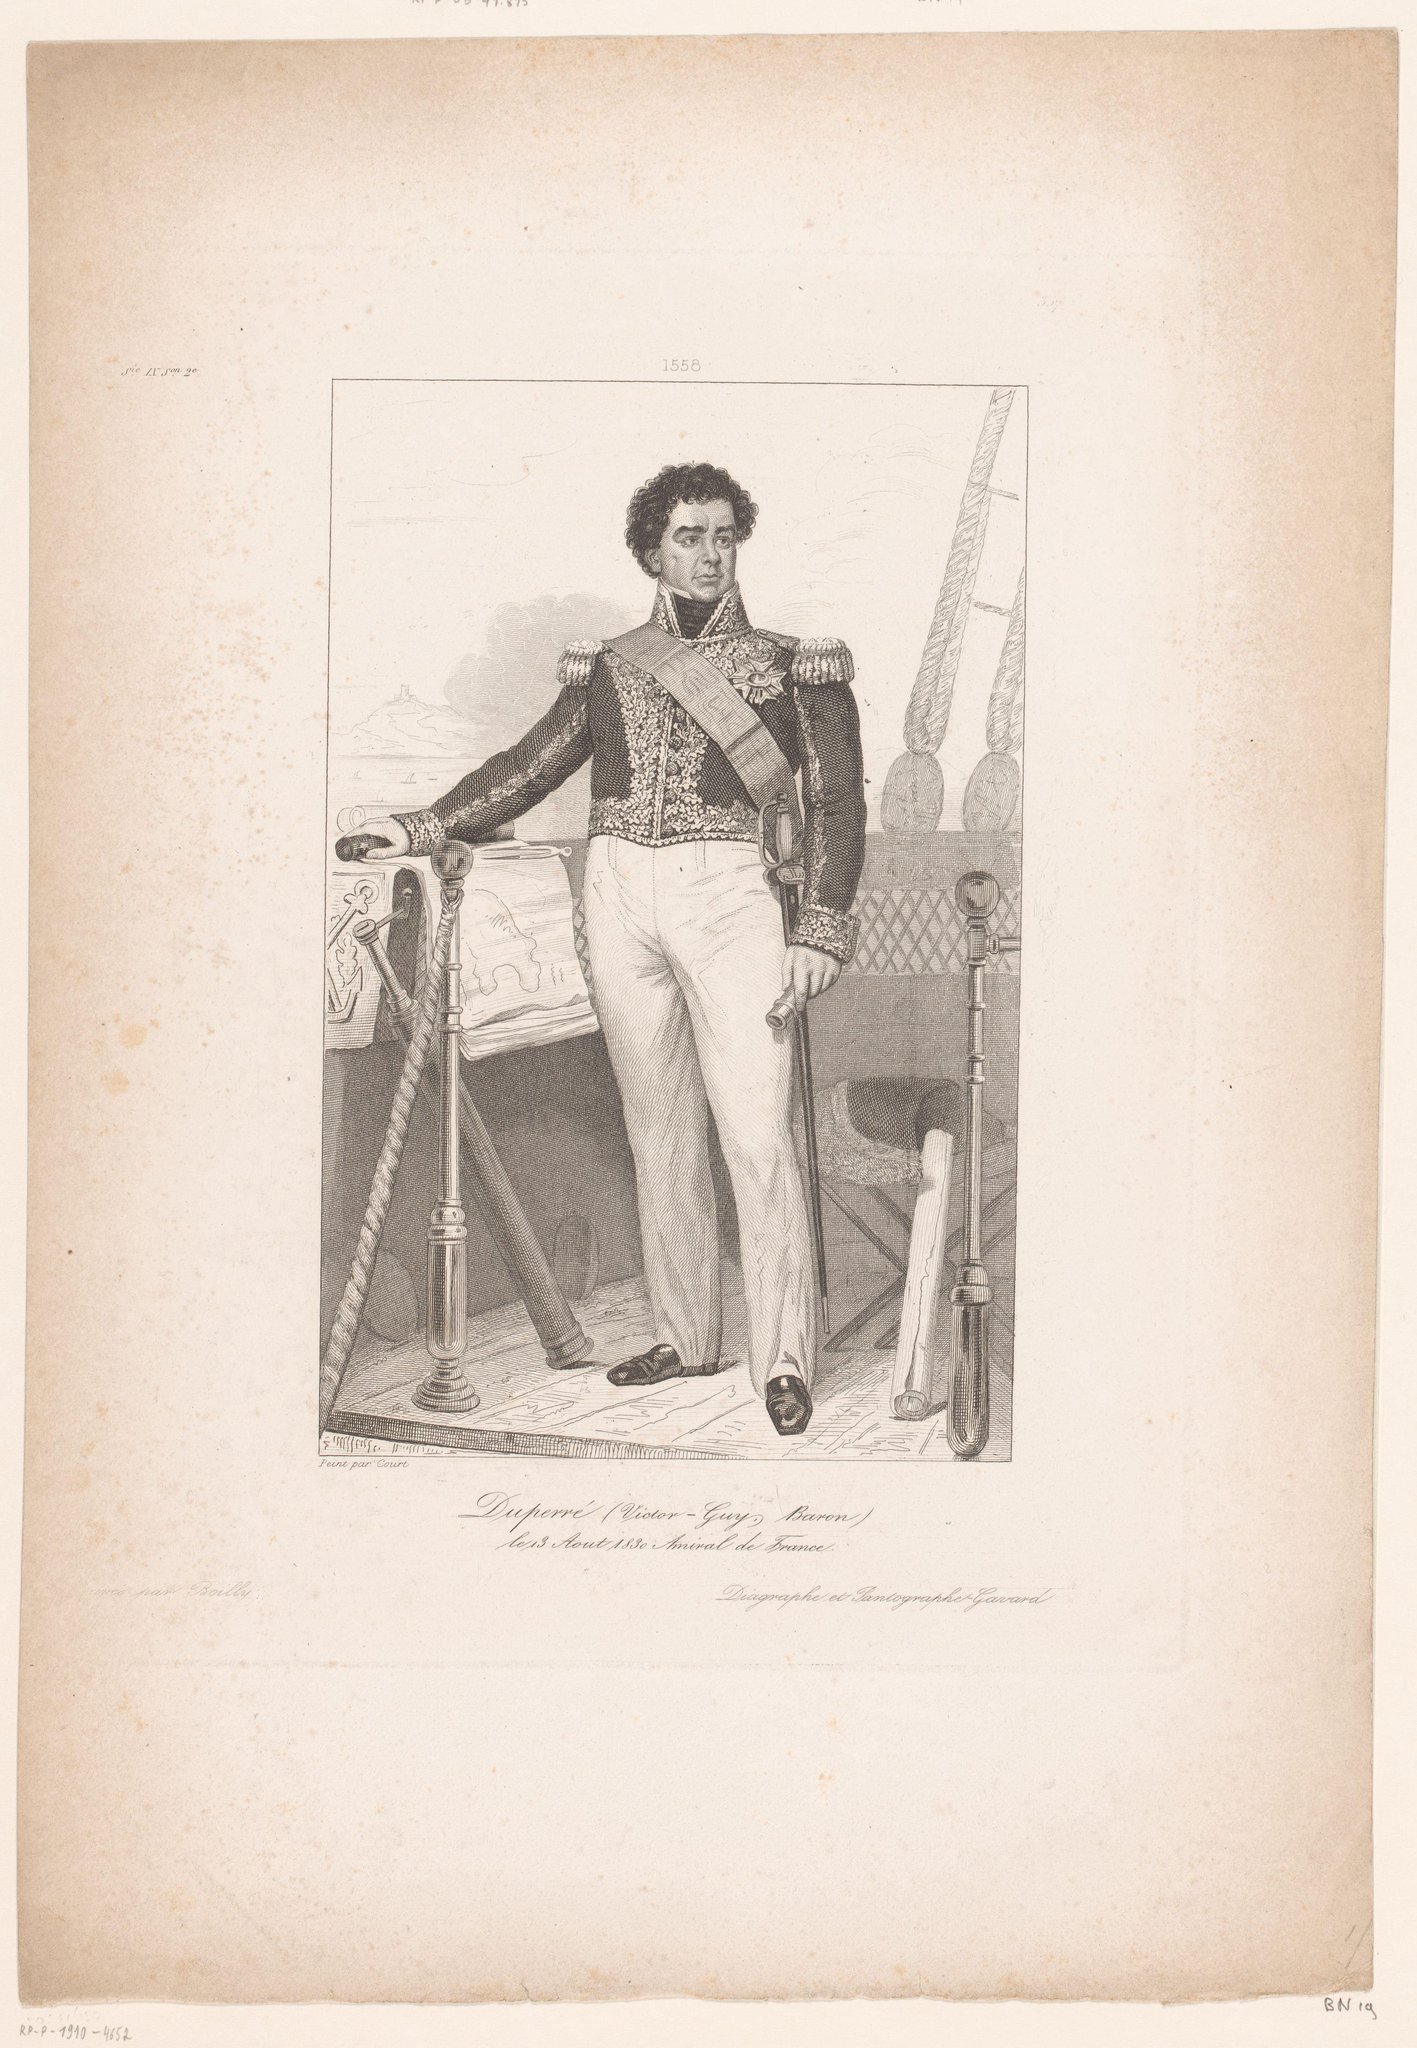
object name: print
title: Portret van baron Guy-Victor Duperré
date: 1811-1867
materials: paper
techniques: engraving, etching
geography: france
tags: paris, historical persons, parts of ship's interior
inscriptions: collector's mark: Lugt 2228